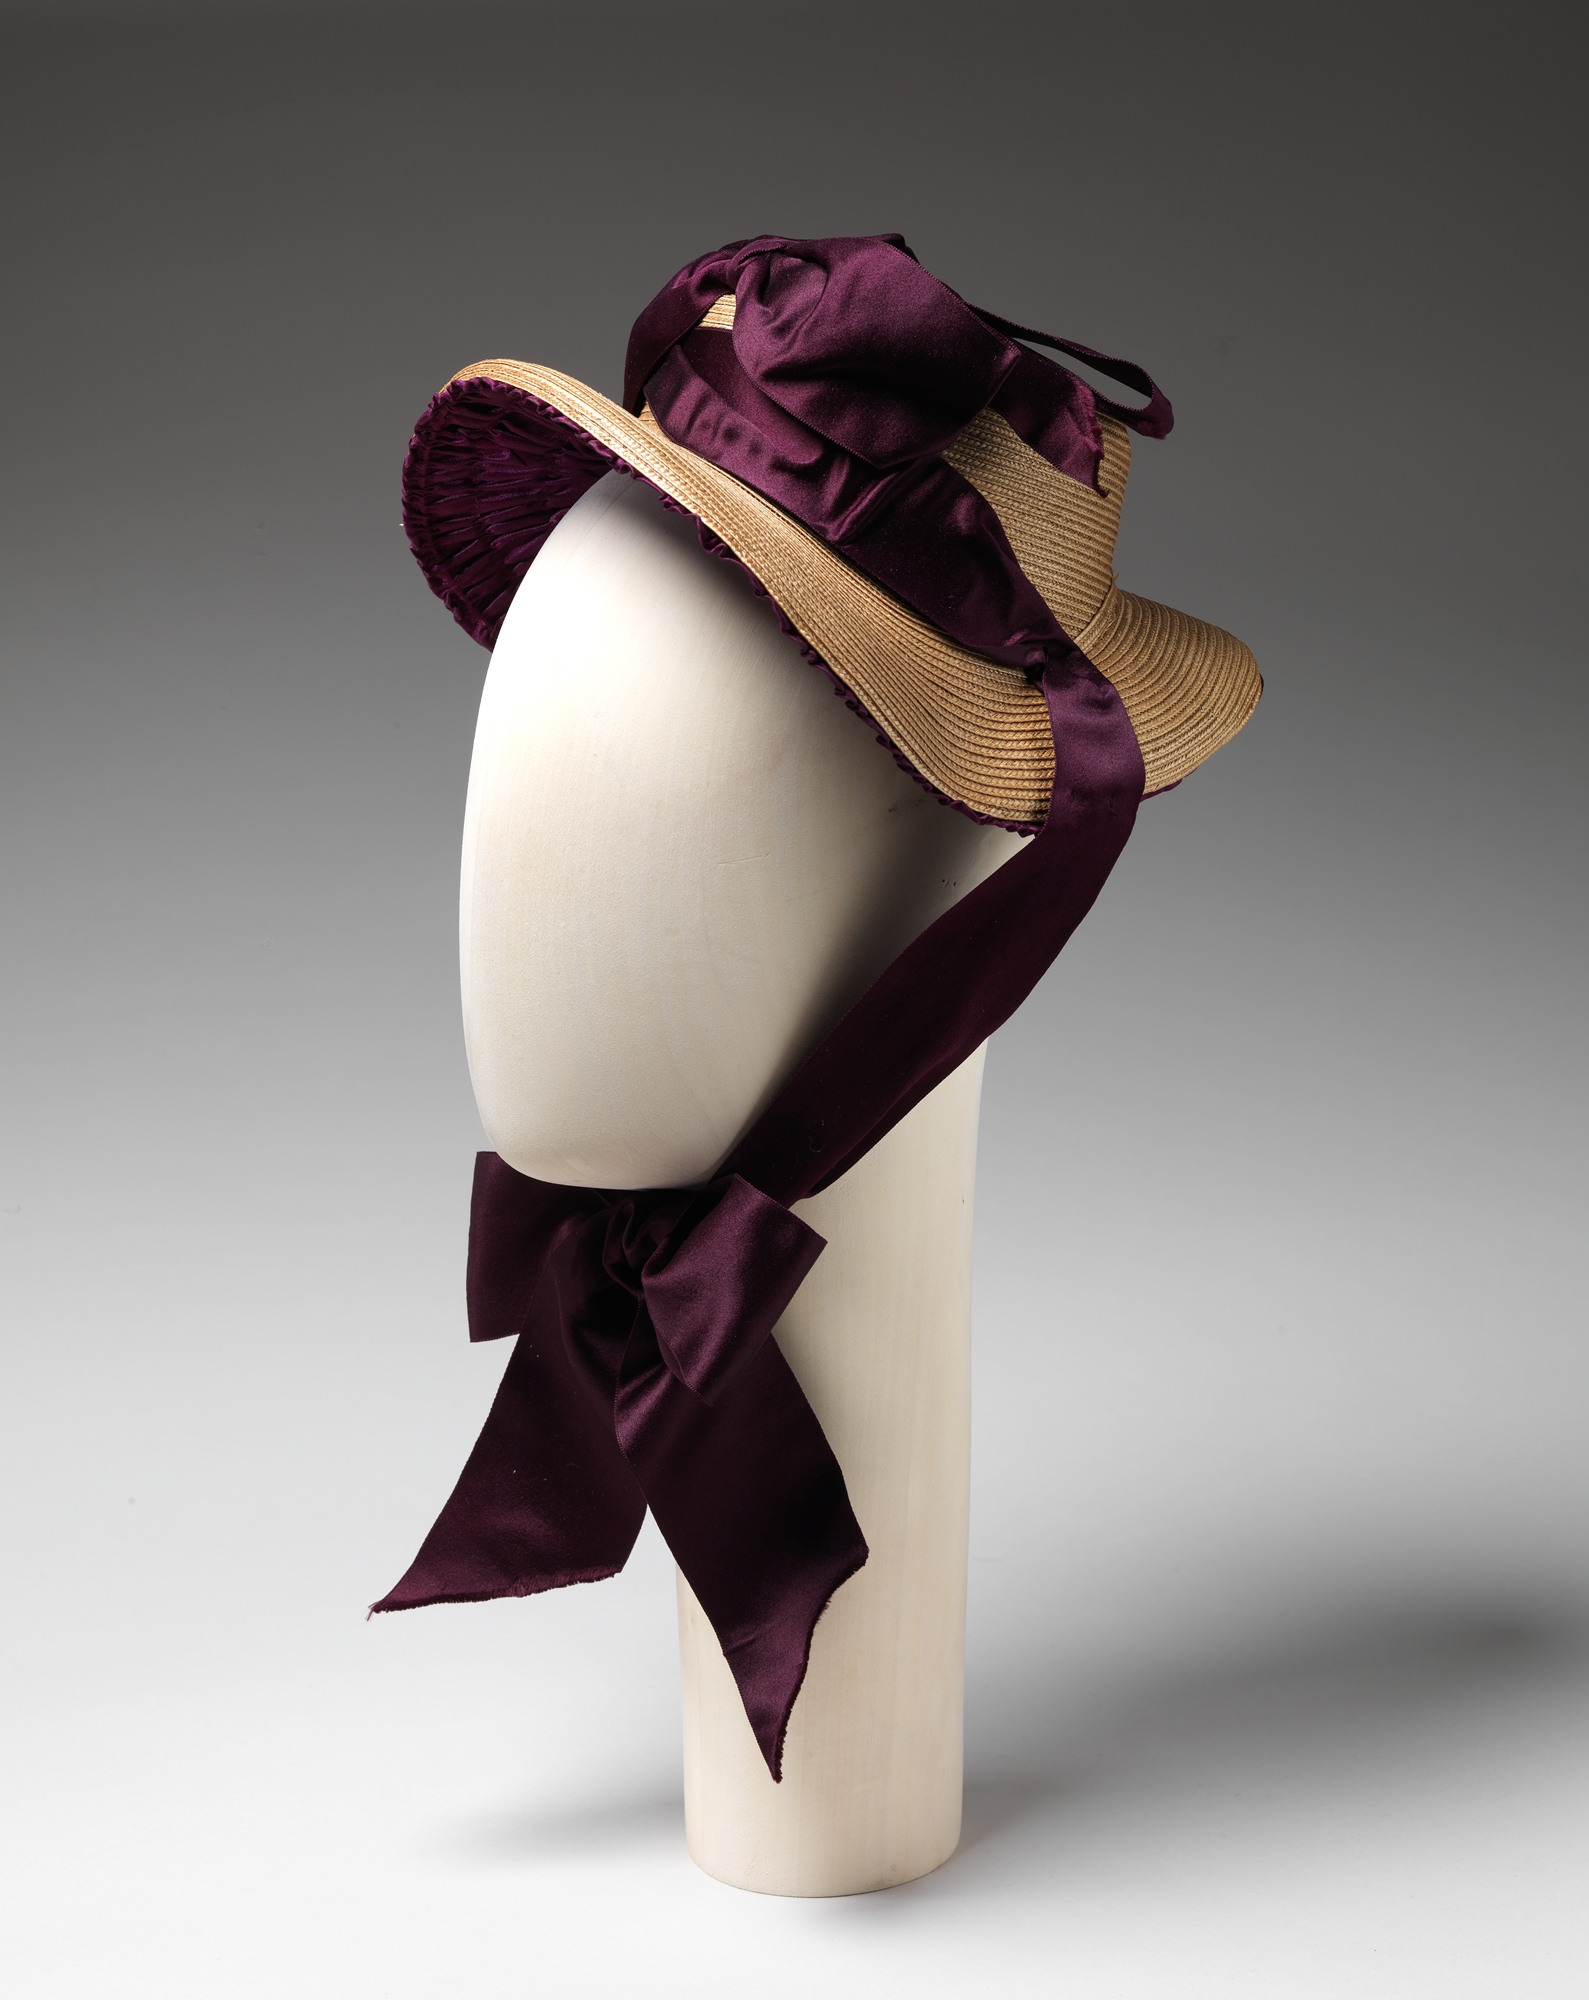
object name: promenade bonnet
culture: american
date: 1882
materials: silk, fiber